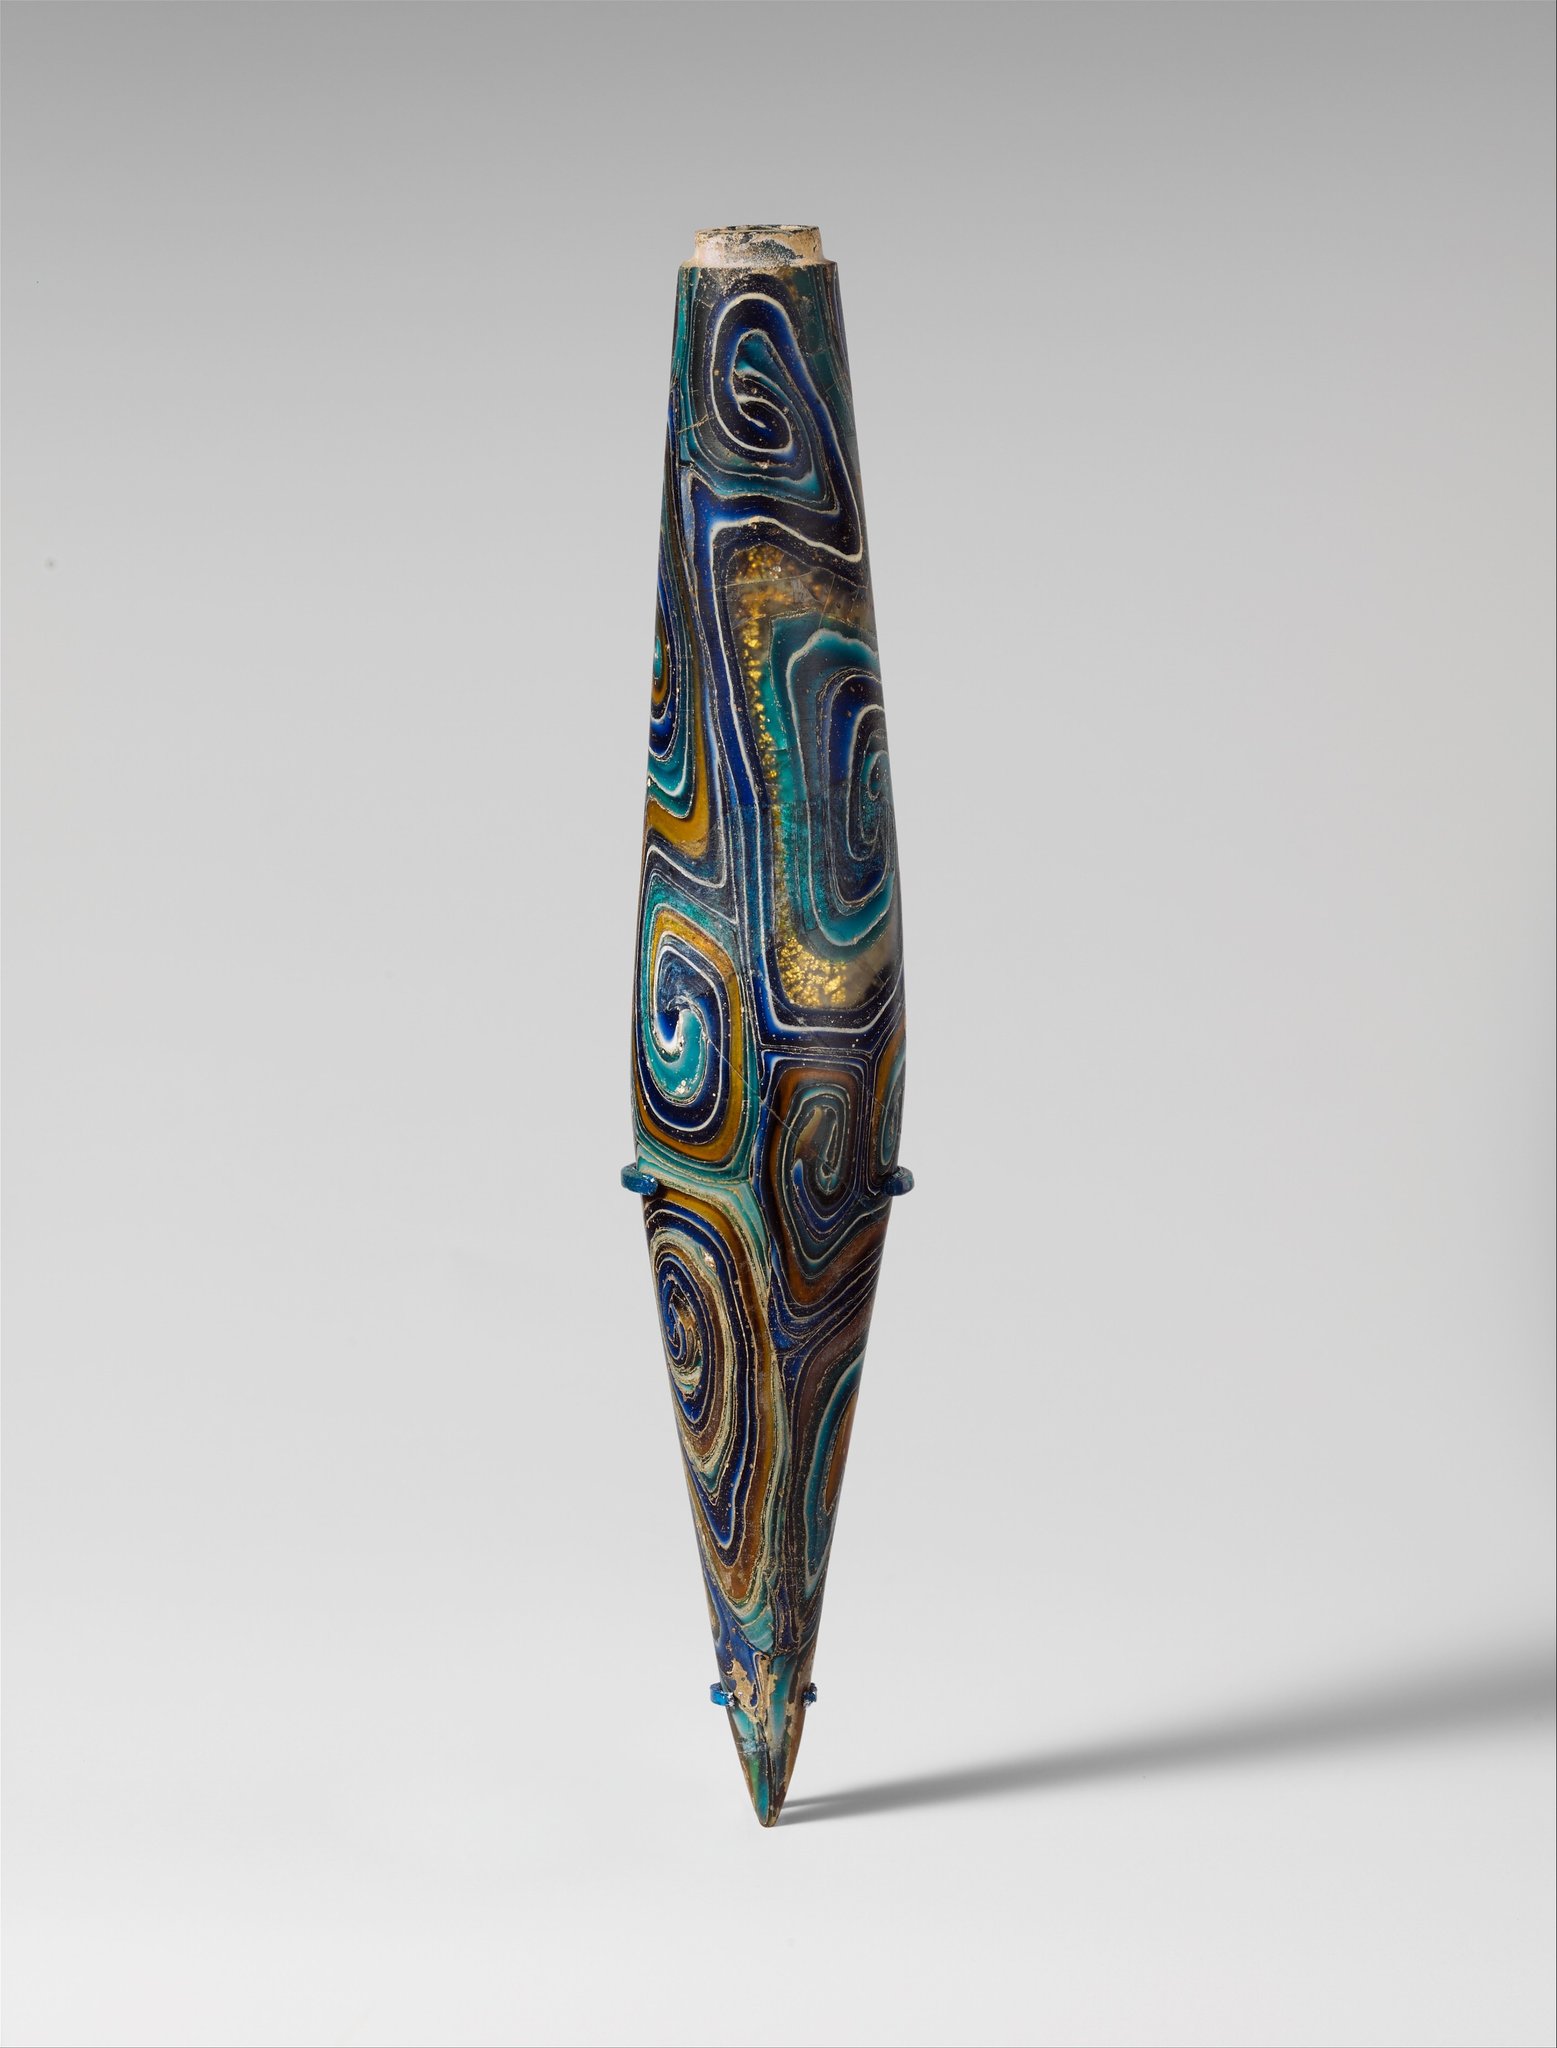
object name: alabastron, gold band mosaic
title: Glass gold-band mosaic alabastron (perfume bottle)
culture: greek, eastern mediterranean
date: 100-1 BCE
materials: glass